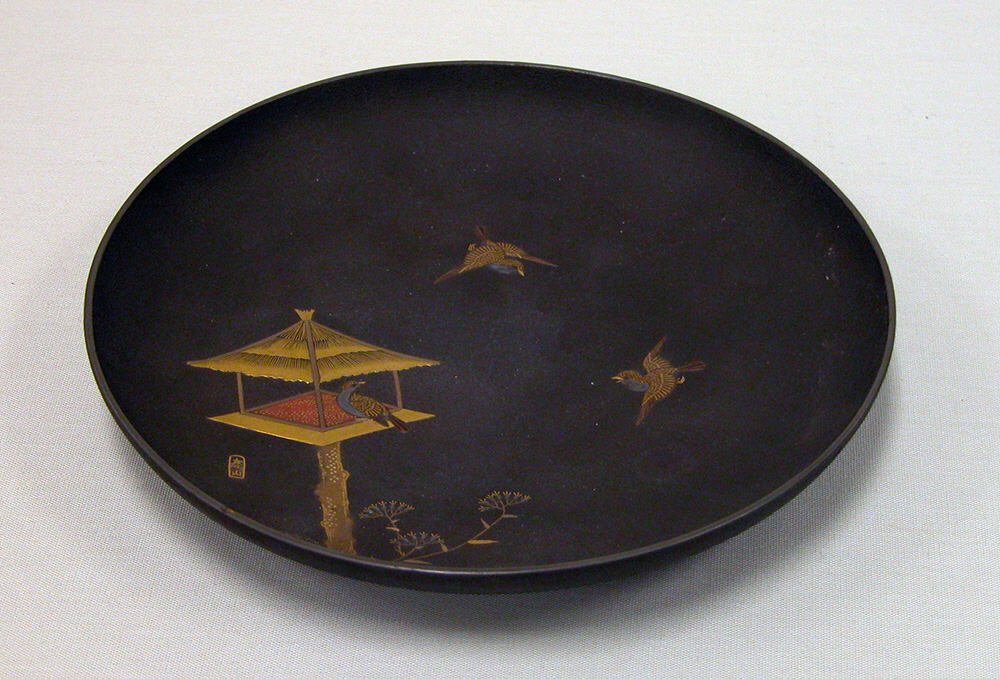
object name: cake tray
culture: japanese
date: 1801-1900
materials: gold, lacquer, silver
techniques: hiramakie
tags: birds